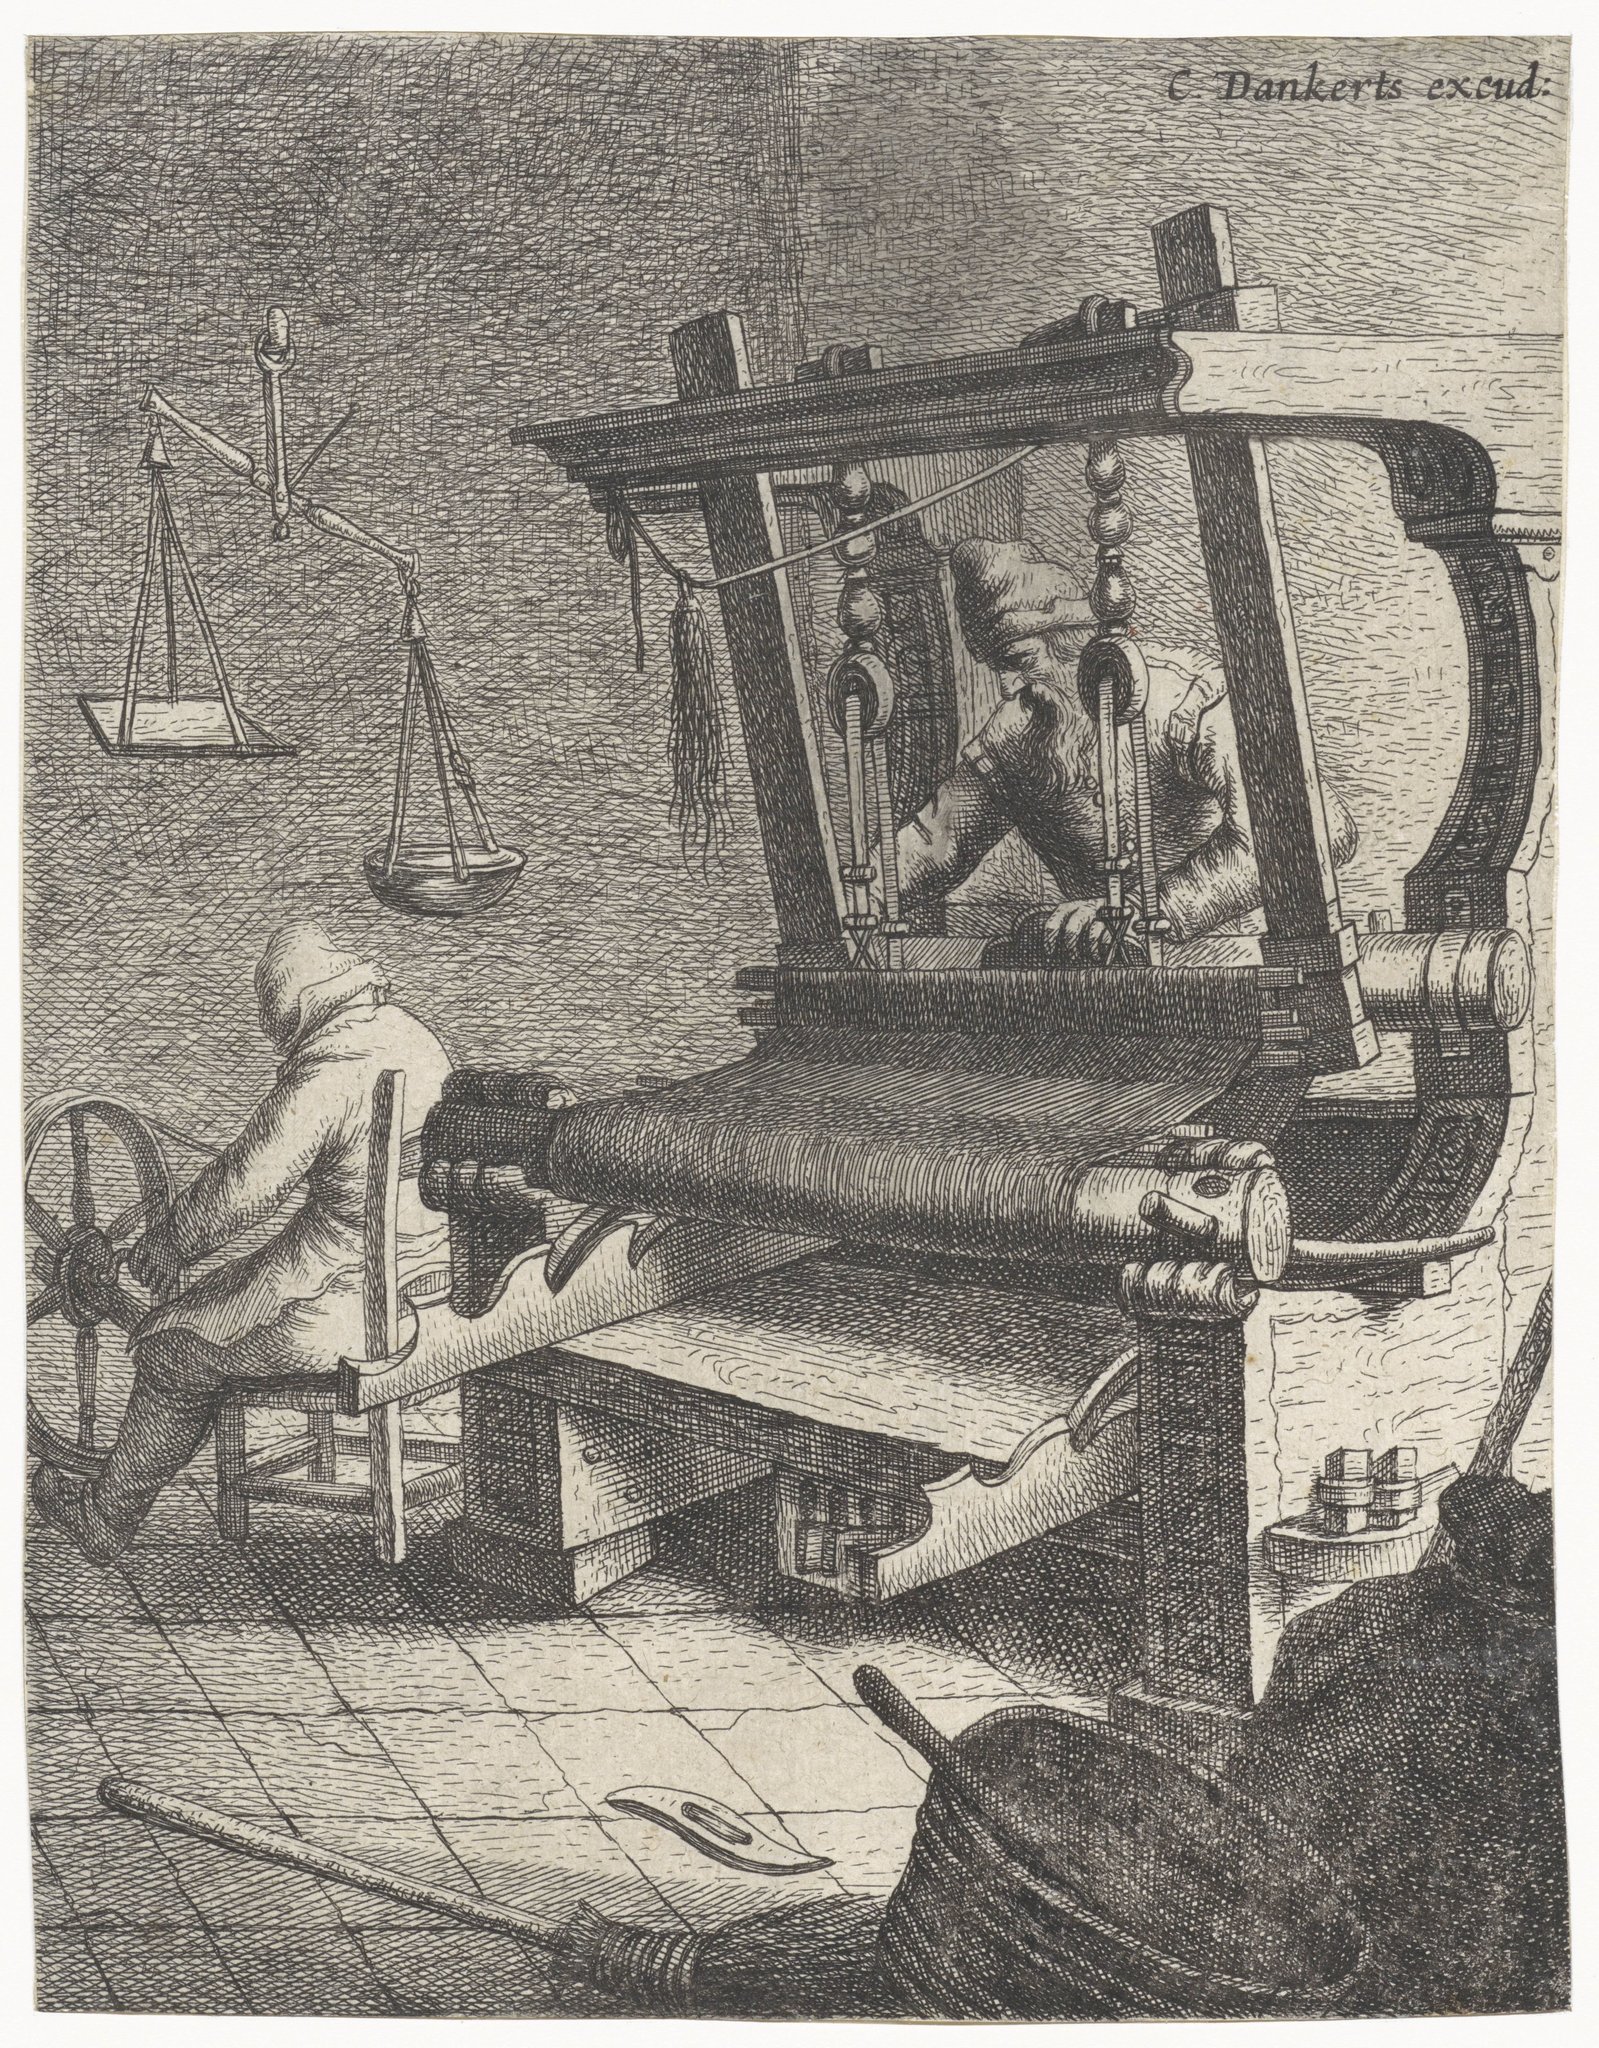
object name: print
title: Wever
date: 1635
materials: paper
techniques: etching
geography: amsterdam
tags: scales, weaving-loom, weaving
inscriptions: collector's mark: Lugt 2228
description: Wevers in een werkplaats. Een man staat achter een weefgetouw en links zit een man bij een vliegwiel. Aan de wand hangt een balans.